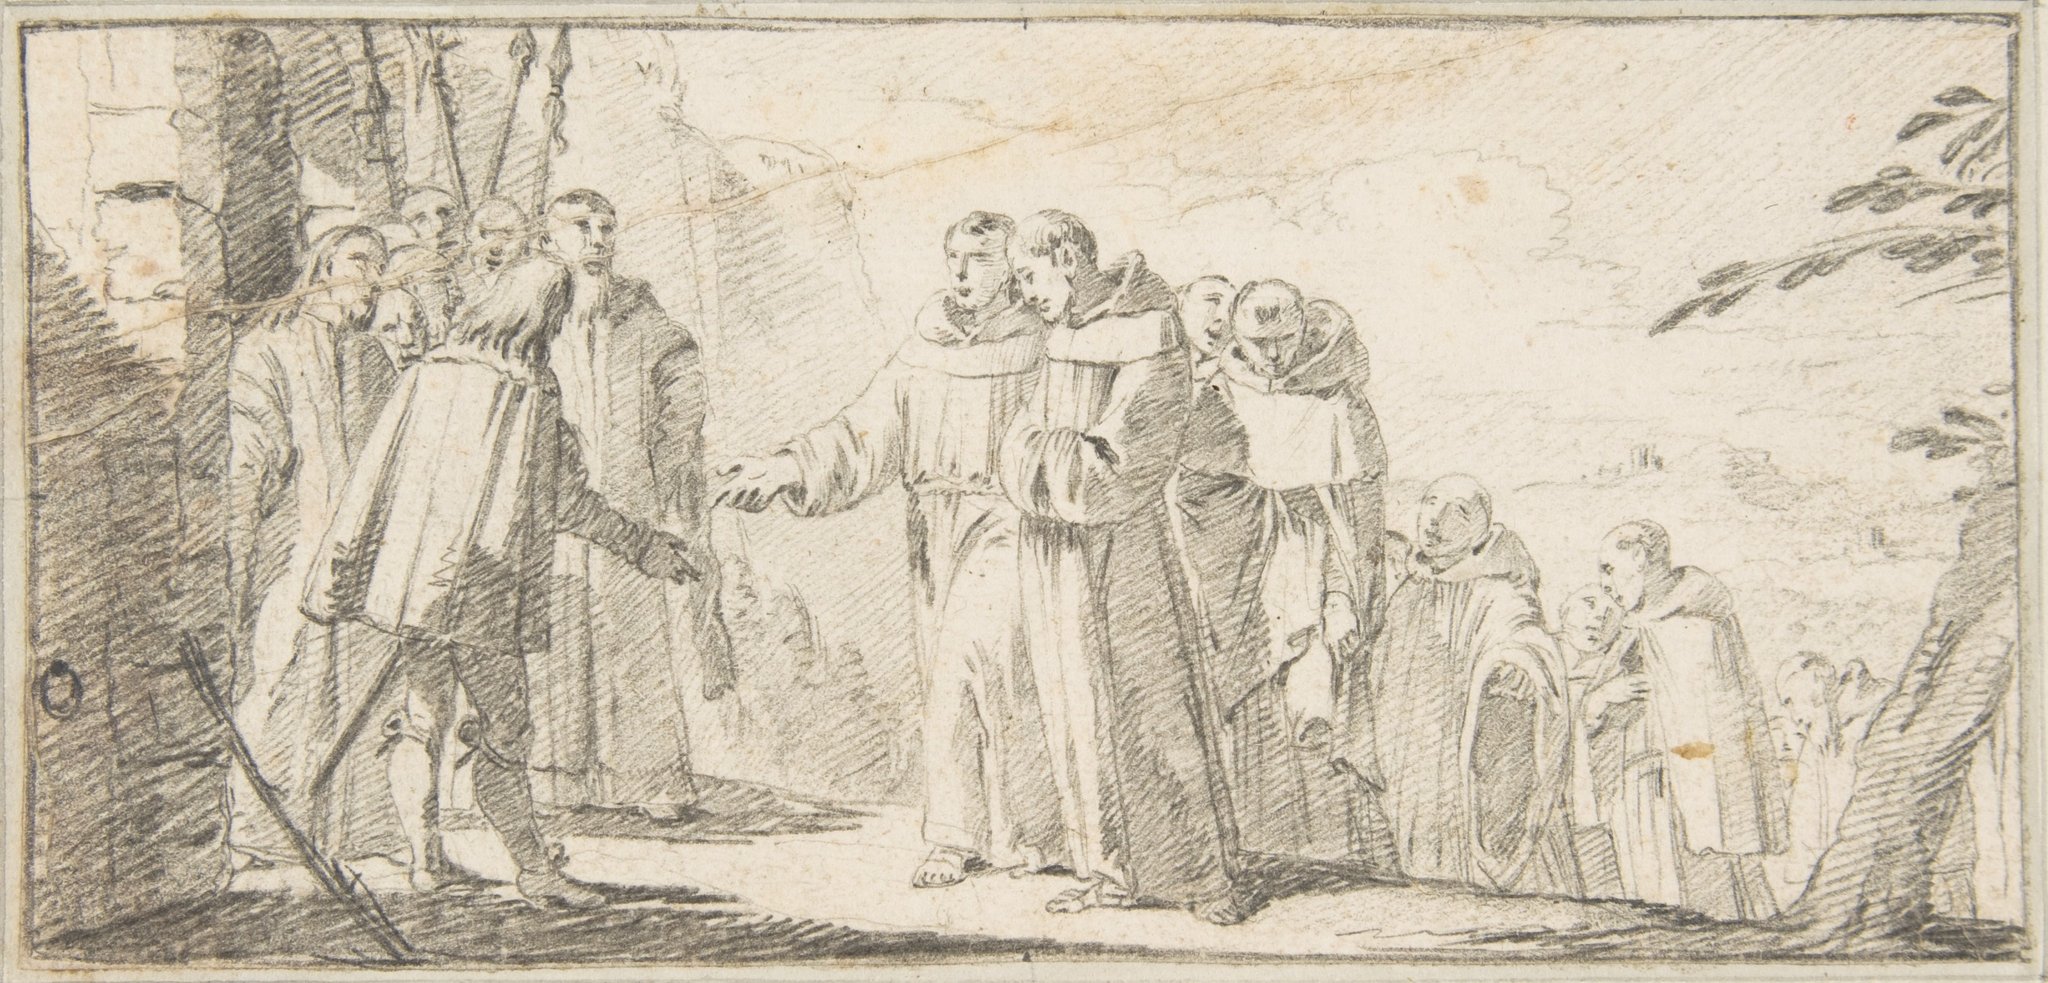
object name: drawing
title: Illustration for a Book: Reception of Monks at a City Gate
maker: giovanni battista tiepolo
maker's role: artist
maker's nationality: italian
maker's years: 1696-1770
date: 1696-1770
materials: chalk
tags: gates,monks